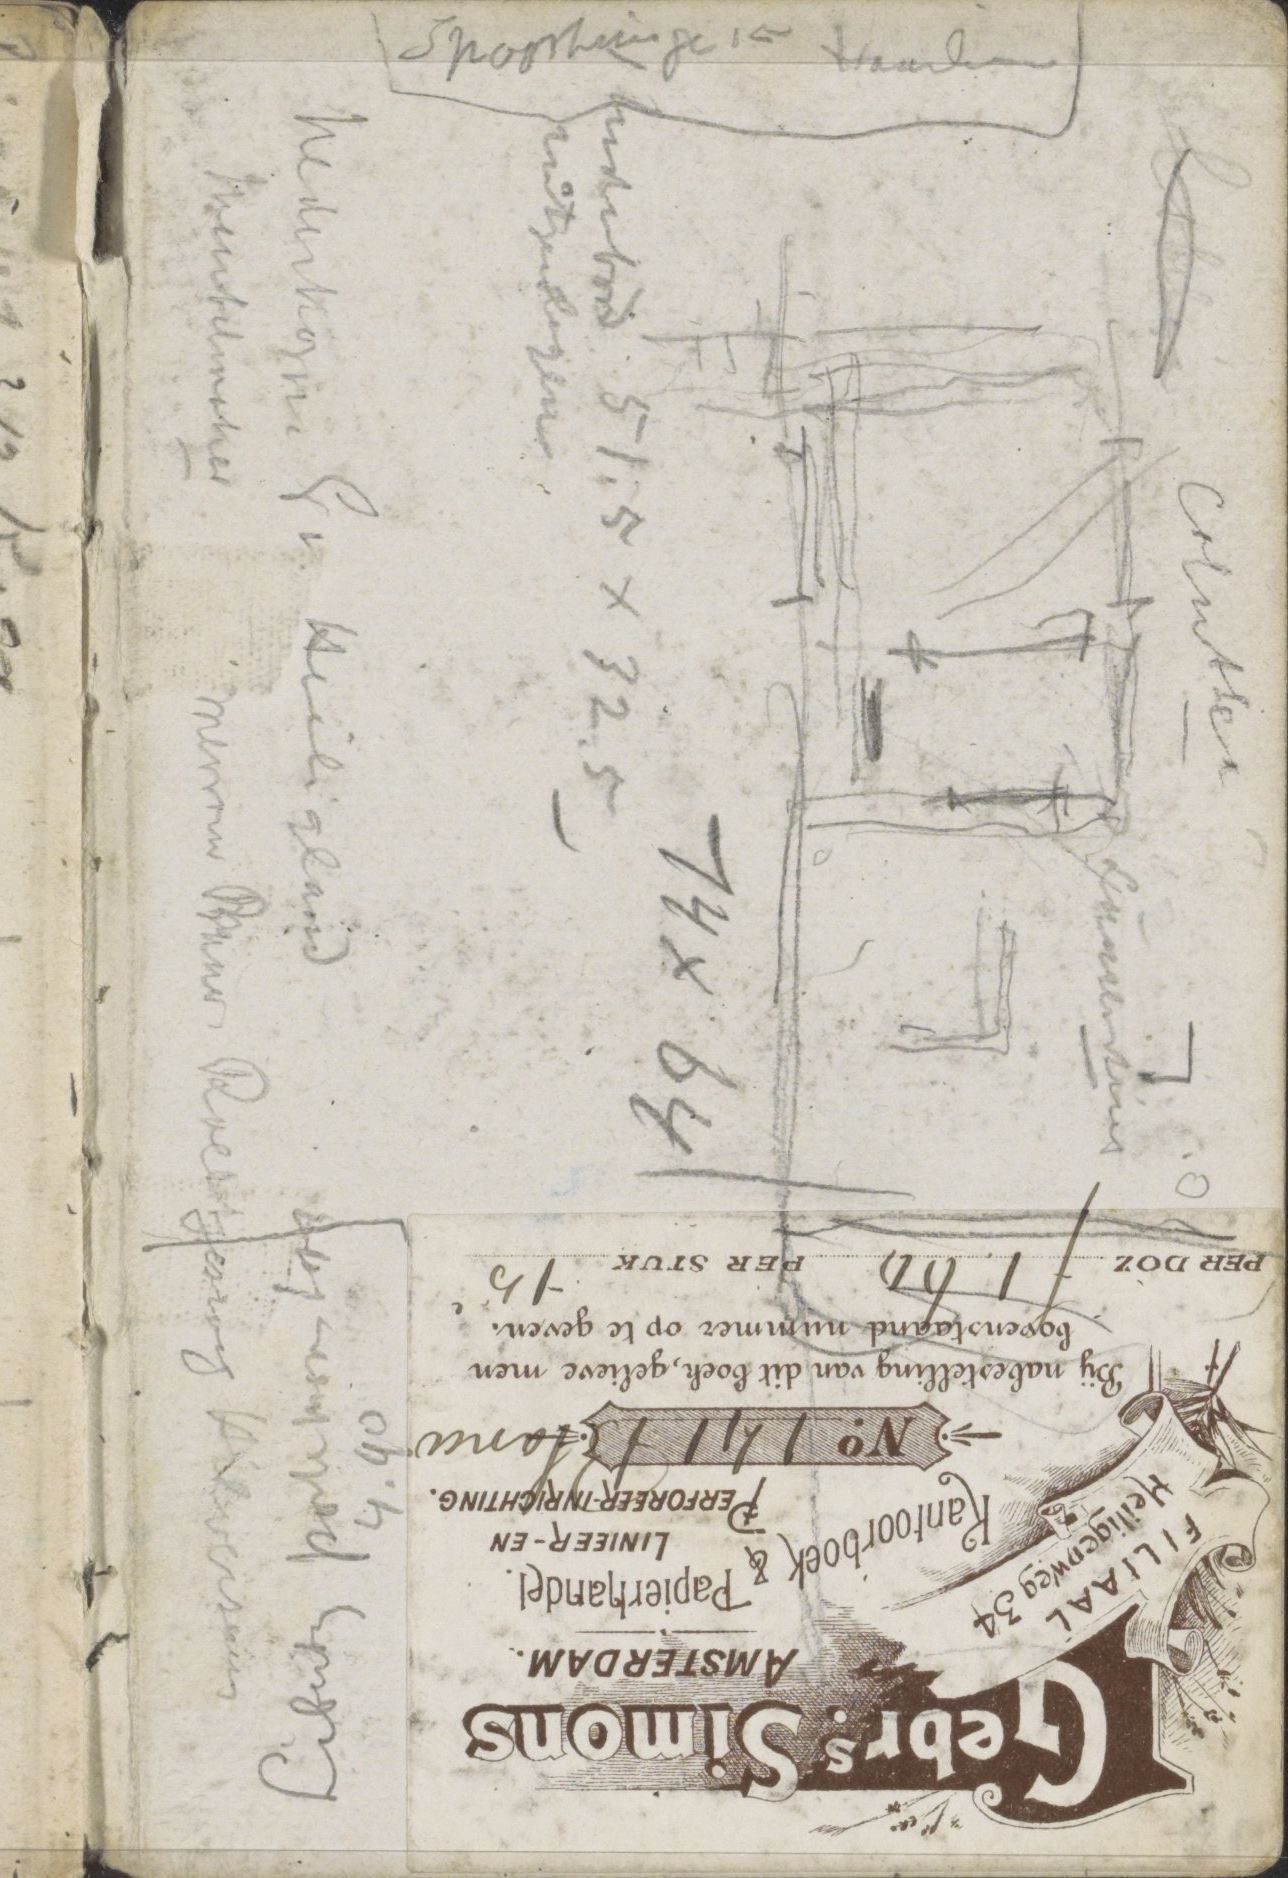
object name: endleaf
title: Studie en annotaties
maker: george hendrik breitner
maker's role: draughtsman, painter, print maker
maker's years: 1857-1923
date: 1903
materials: paper, pencil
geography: amsterdam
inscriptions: annotation: ‘Meubelmaker mevrouw Bauer[?] Roeltjesweg Hilversum’, retailer's mark: ‘Gebrs. Simons/ Amsterdam./ Filiaal/ Heiligenweg 34/ Kantoorboek & Papierhandel./ Linieer- en Perforeer-inrichting./ No. 141 Blanco/ Bij nabestelling van dit boek, gelieve men/ bovenstaand nummer op te geven. / per doz f 1.60 per stuk 15’, annotation, annotation: ‘Spoor[...] 15 Haarlem’, annotation: ‘Neder[...] Gr. Heiligland’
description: Studie en aantekeningen. Pagina 94, achterste schutblad, uit een schetsboek met 46 bladen vervaardigd te Amsterdam en Haarlem.